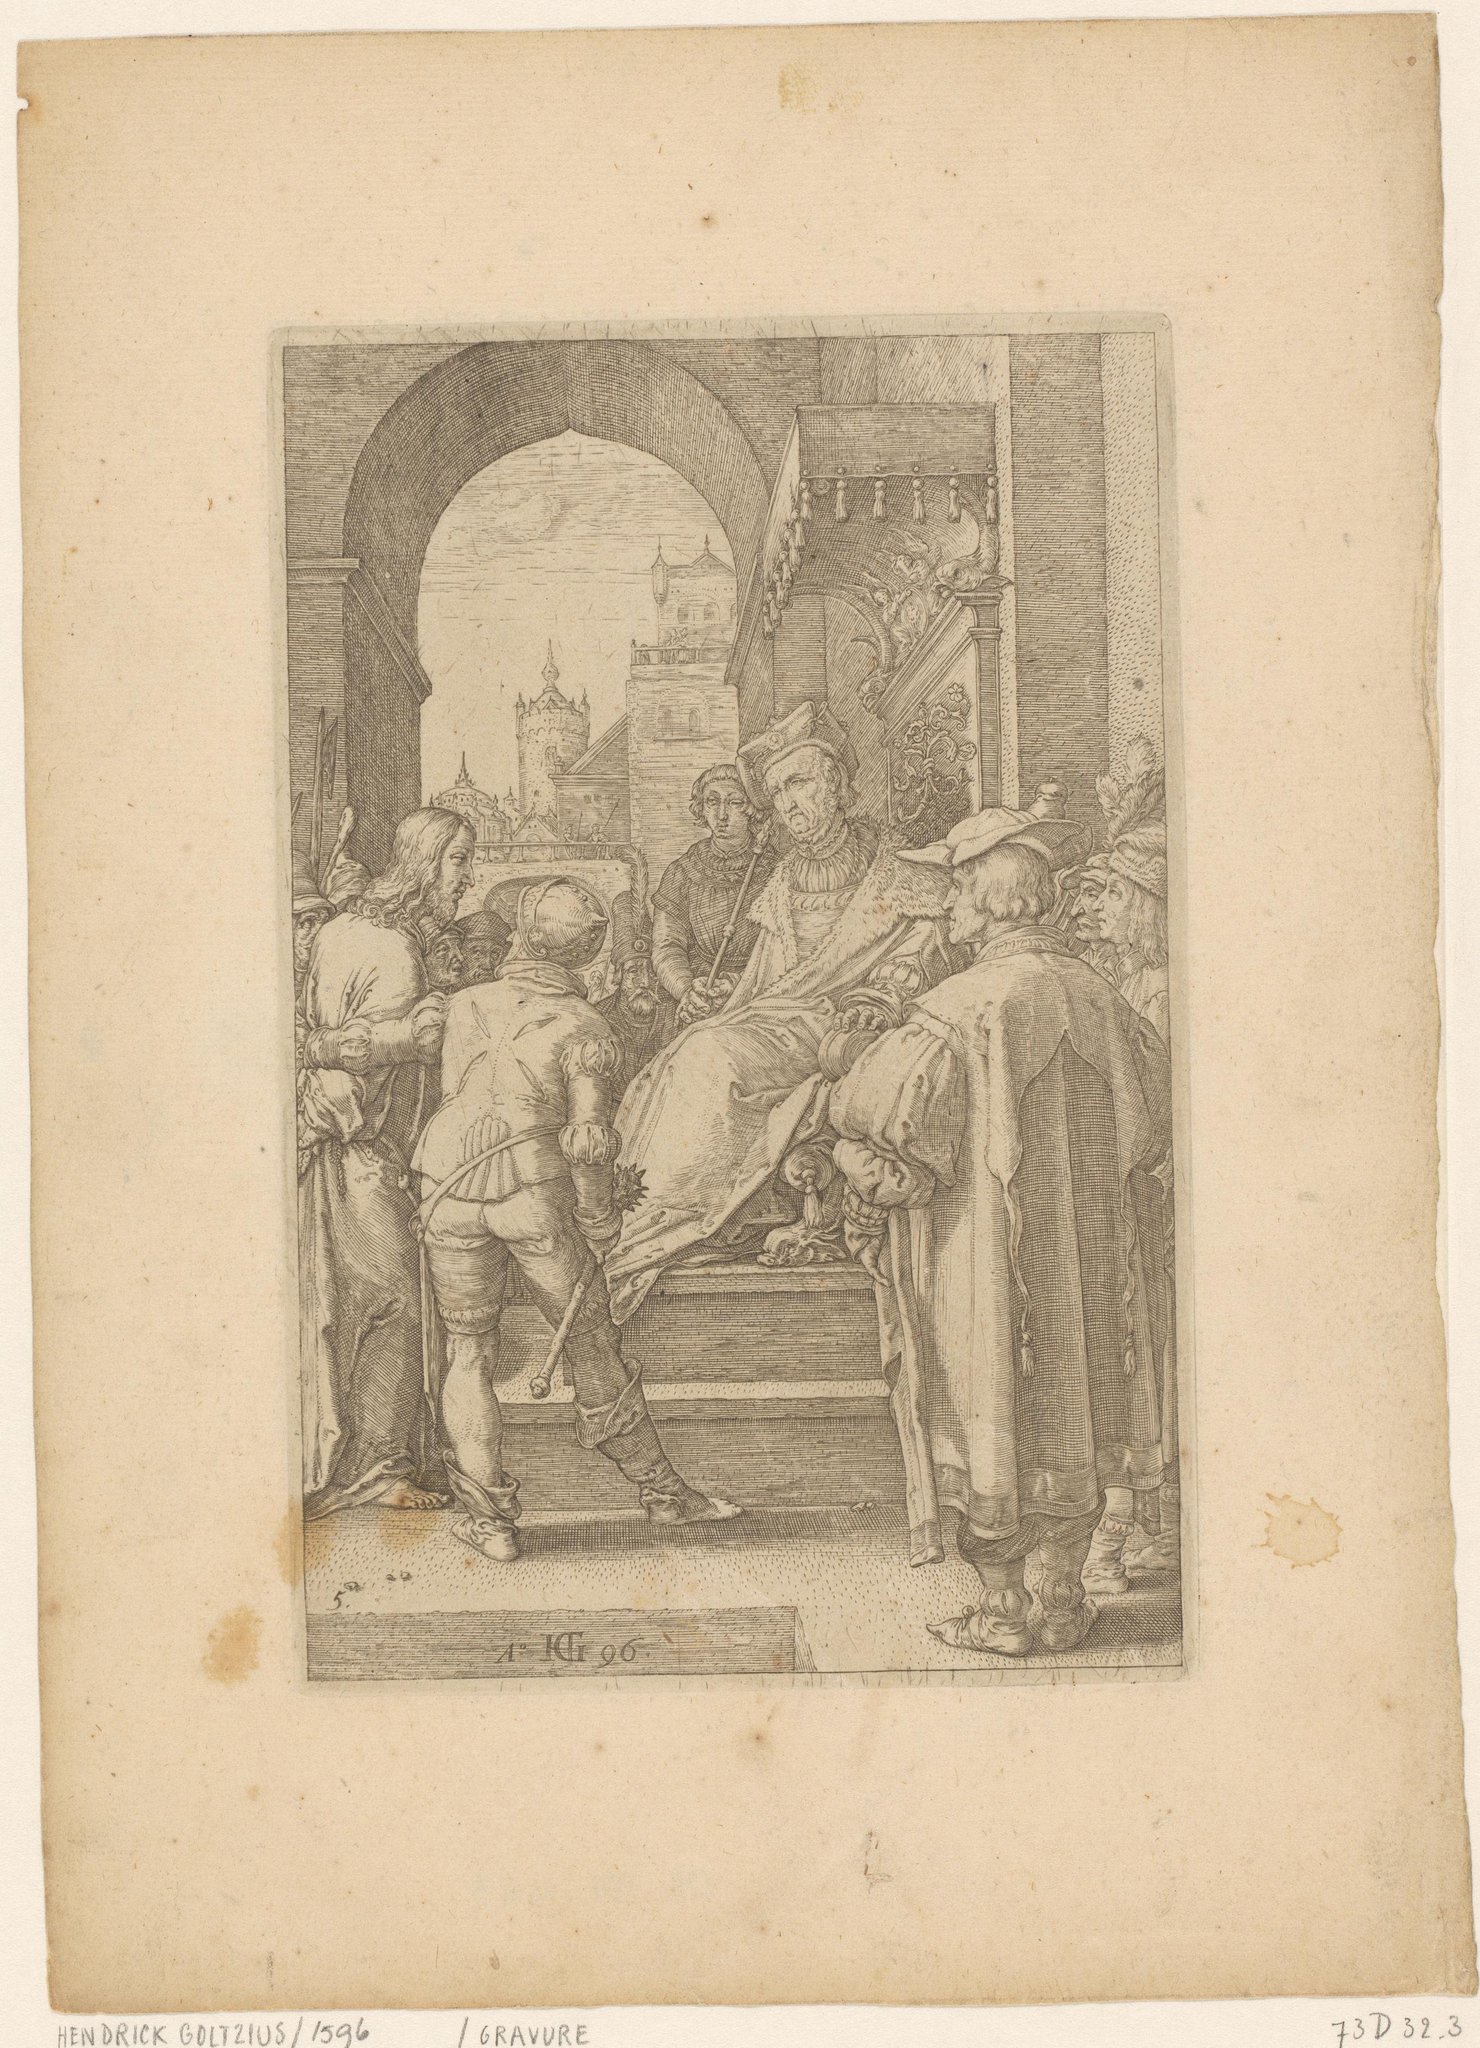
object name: print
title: Passie van Christus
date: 1596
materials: paper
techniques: engraving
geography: haarlem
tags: christ before pontius pilate (matthew 27:11-26; mark 15:2-15; luke 23:2-7, 23:13-25; john 18:28 - 19:16)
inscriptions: monogram and date: ‘Ao HG 96.’, collector's mark: Lugt 2228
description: De twaalf bladen van deze serie zijn gegraveerd in de stijl van Lucas van Leyden, maar ook komen delen van de composities overeen met gedeeltes van Dürers Passie. Er bevindt zich een ongedateerde tekening die gediend heeft als model voor de prent in het Museum für Bildende Kunst in Leipzig (afgebeeld in Reznicek, zie literatuur). Jacobs, G.